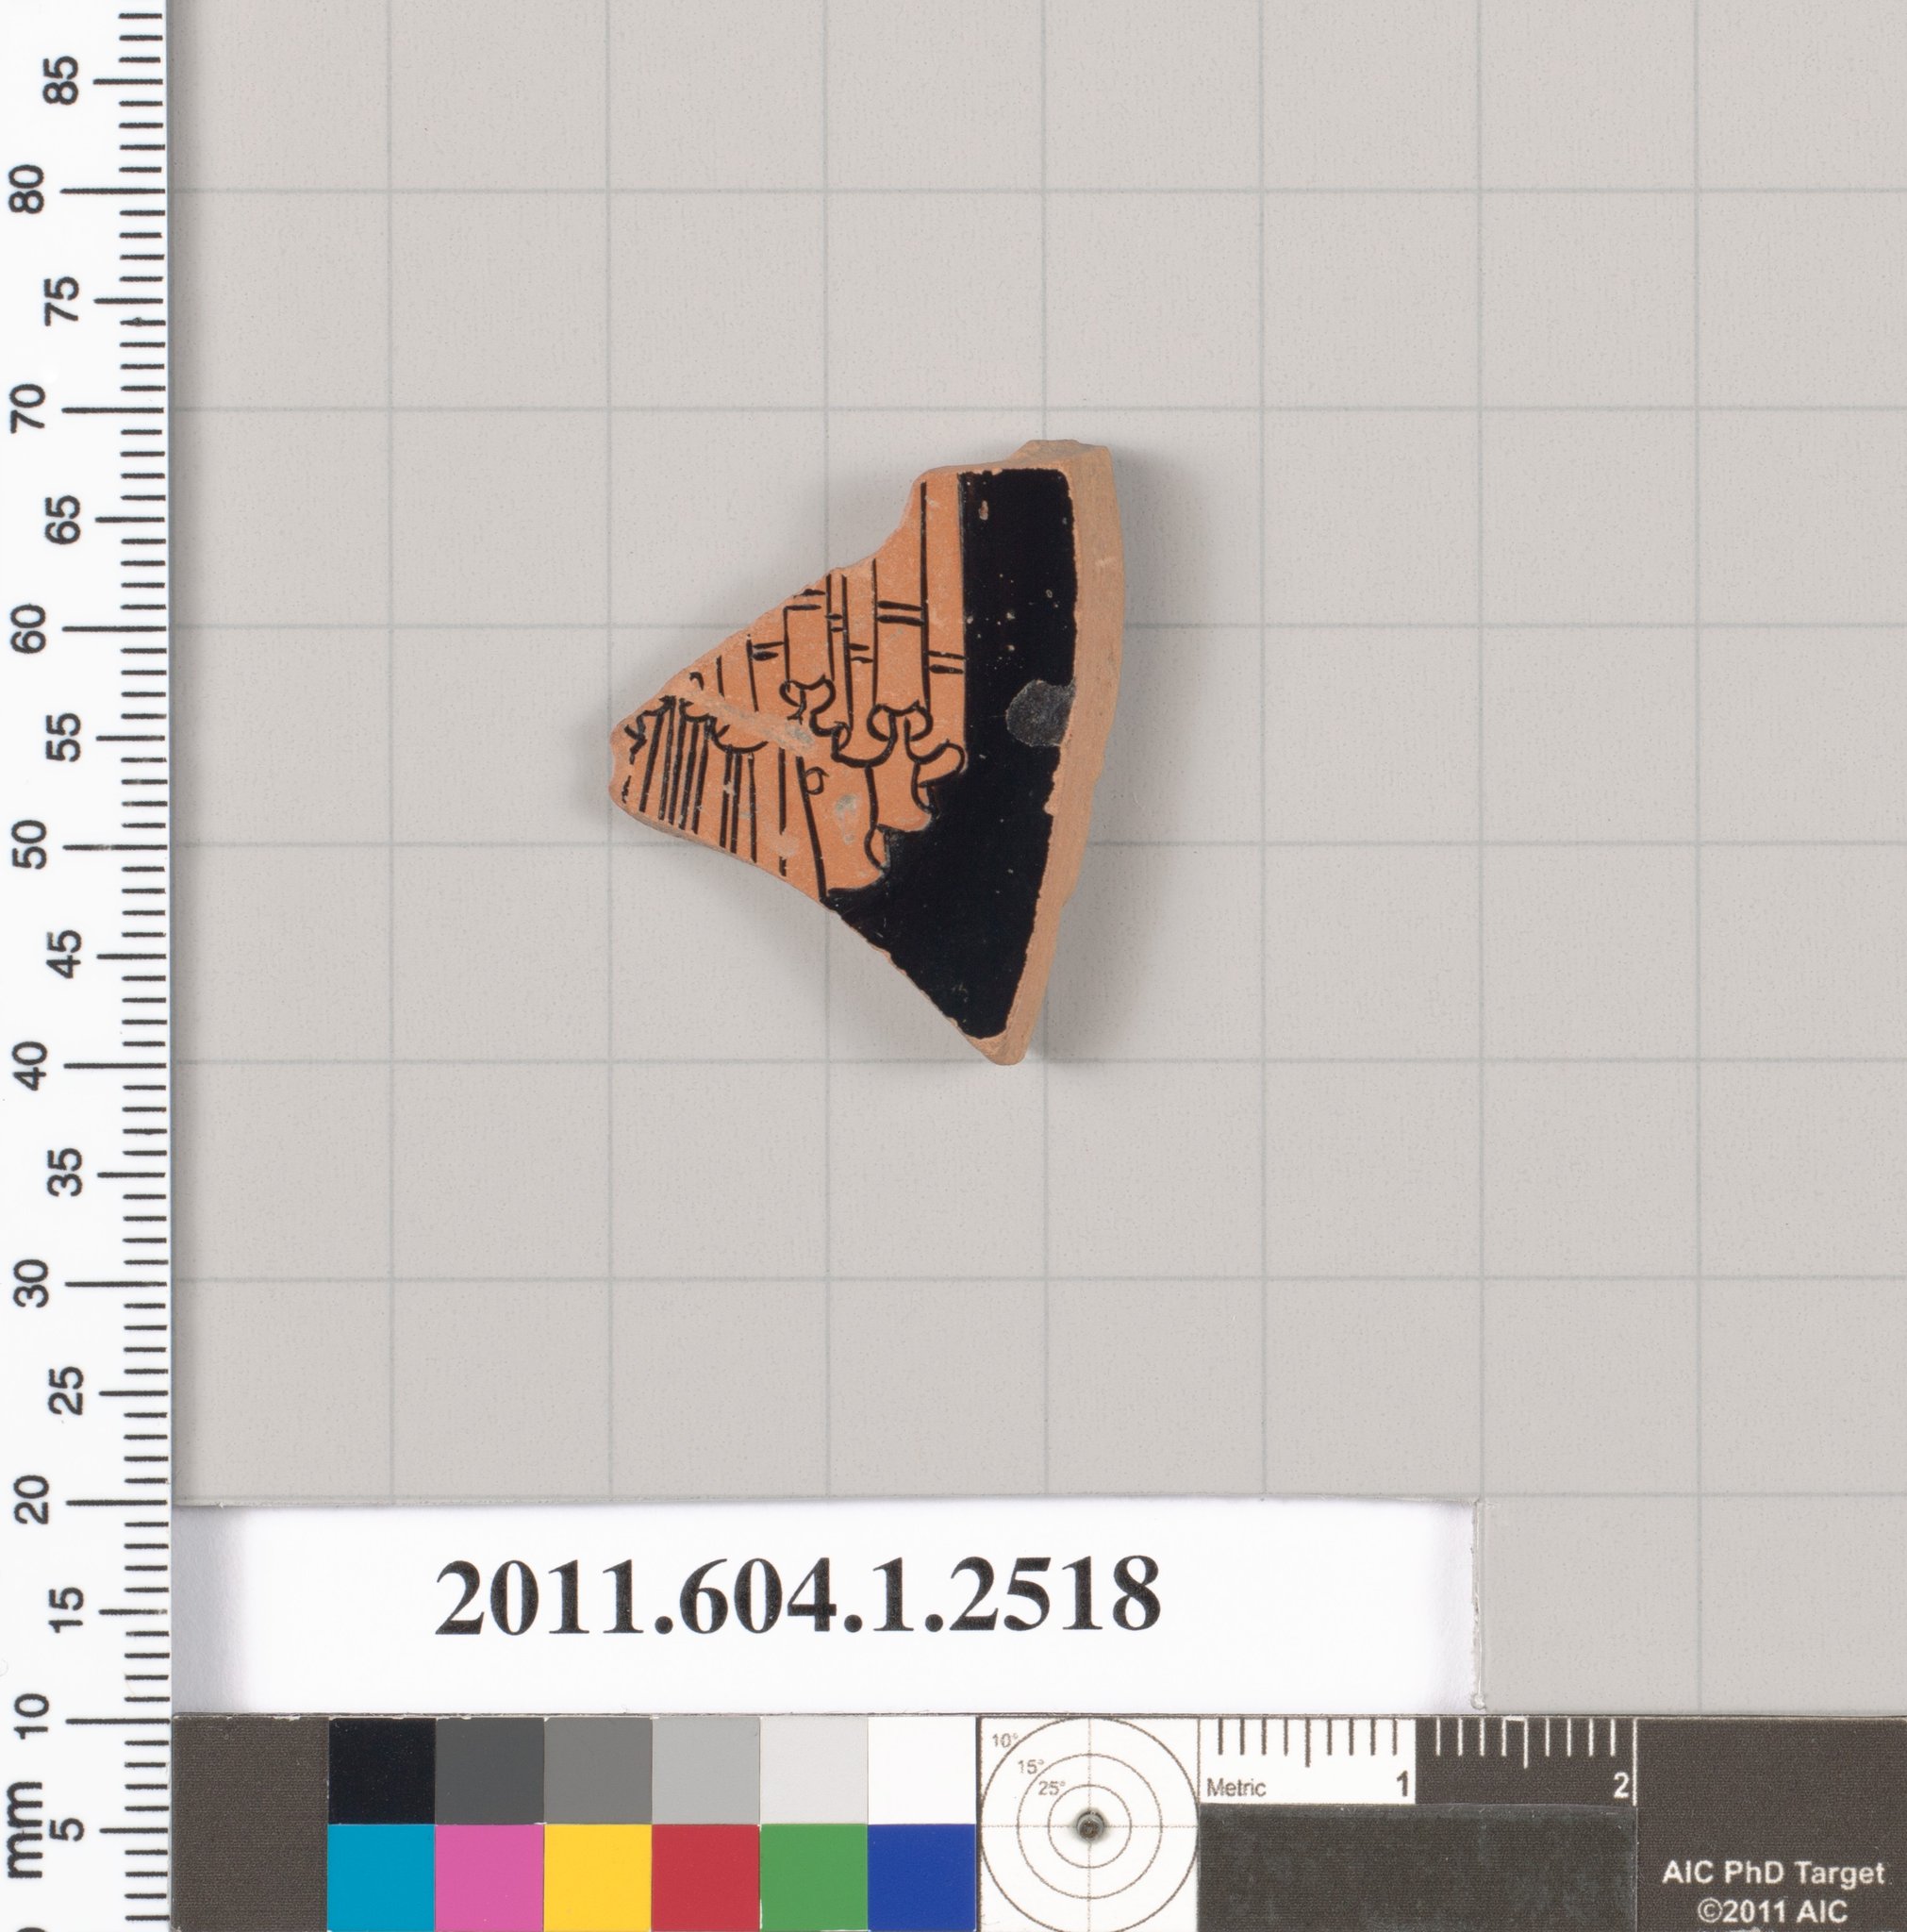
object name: kylix fragment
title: Terracotta fragment of a kylix (drinking cup)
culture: greek, attic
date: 490-480 BCE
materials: terracotta